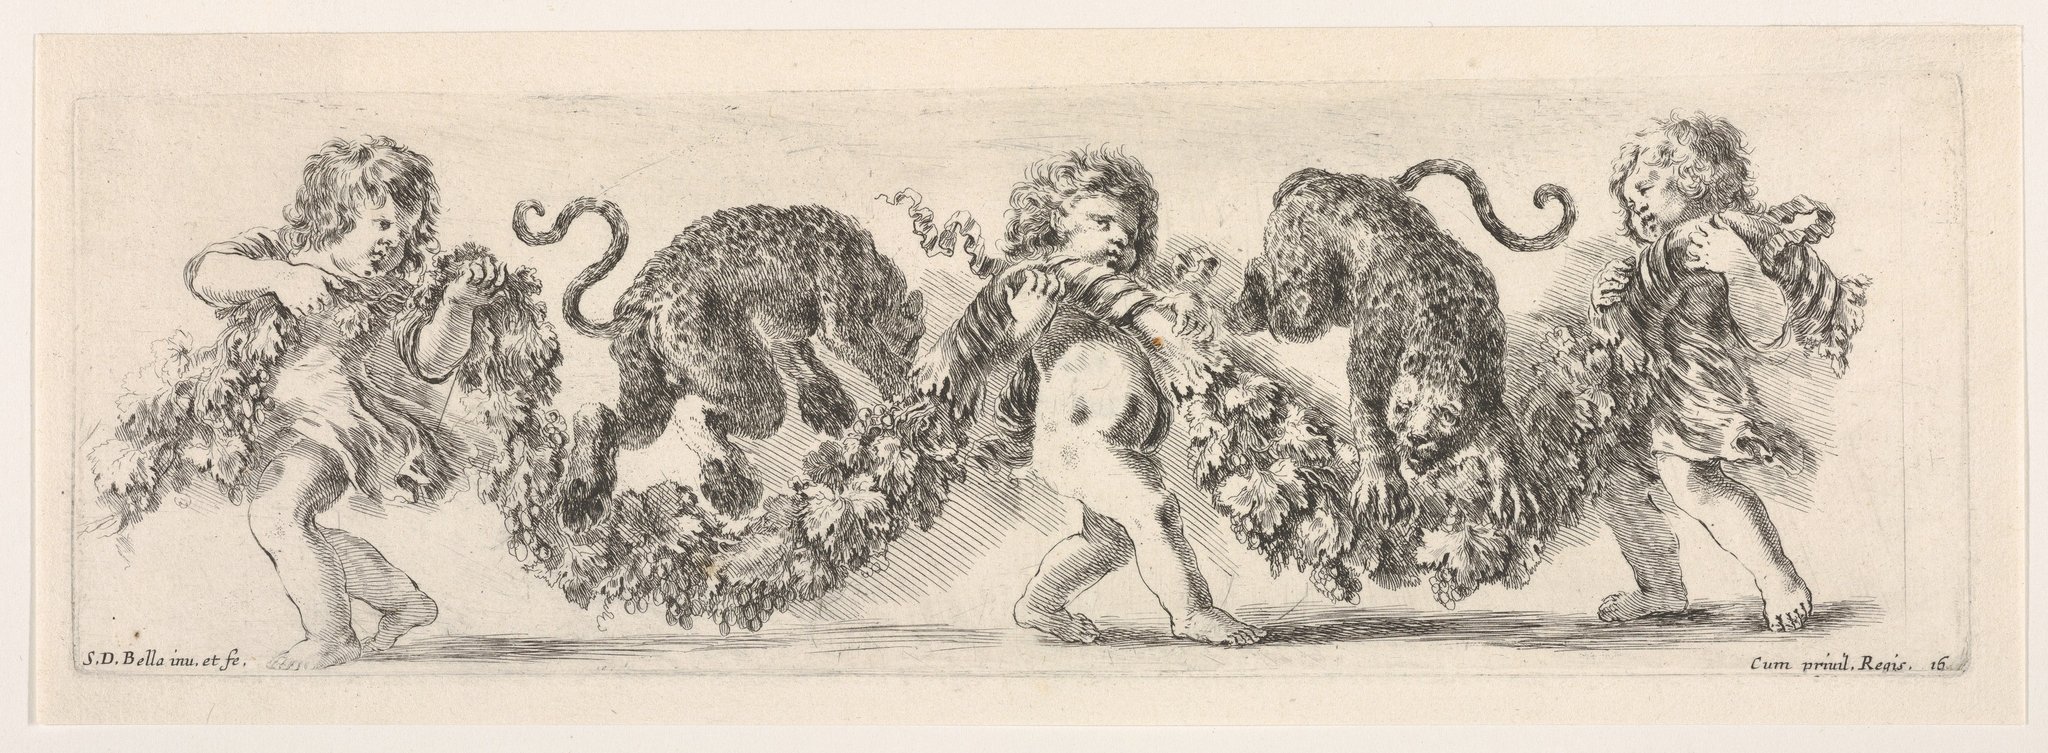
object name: print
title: Design for a Frieze with Three Putti holding a Garland and Two Leopards jumping over it, plate 16 from "Decorative friezes and foliage" (Ornamenti di fregi e fogliami)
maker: stefano della bella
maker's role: artist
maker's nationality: italian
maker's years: 1610-1664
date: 1645-1650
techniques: etching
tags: garlands,putti,leopards